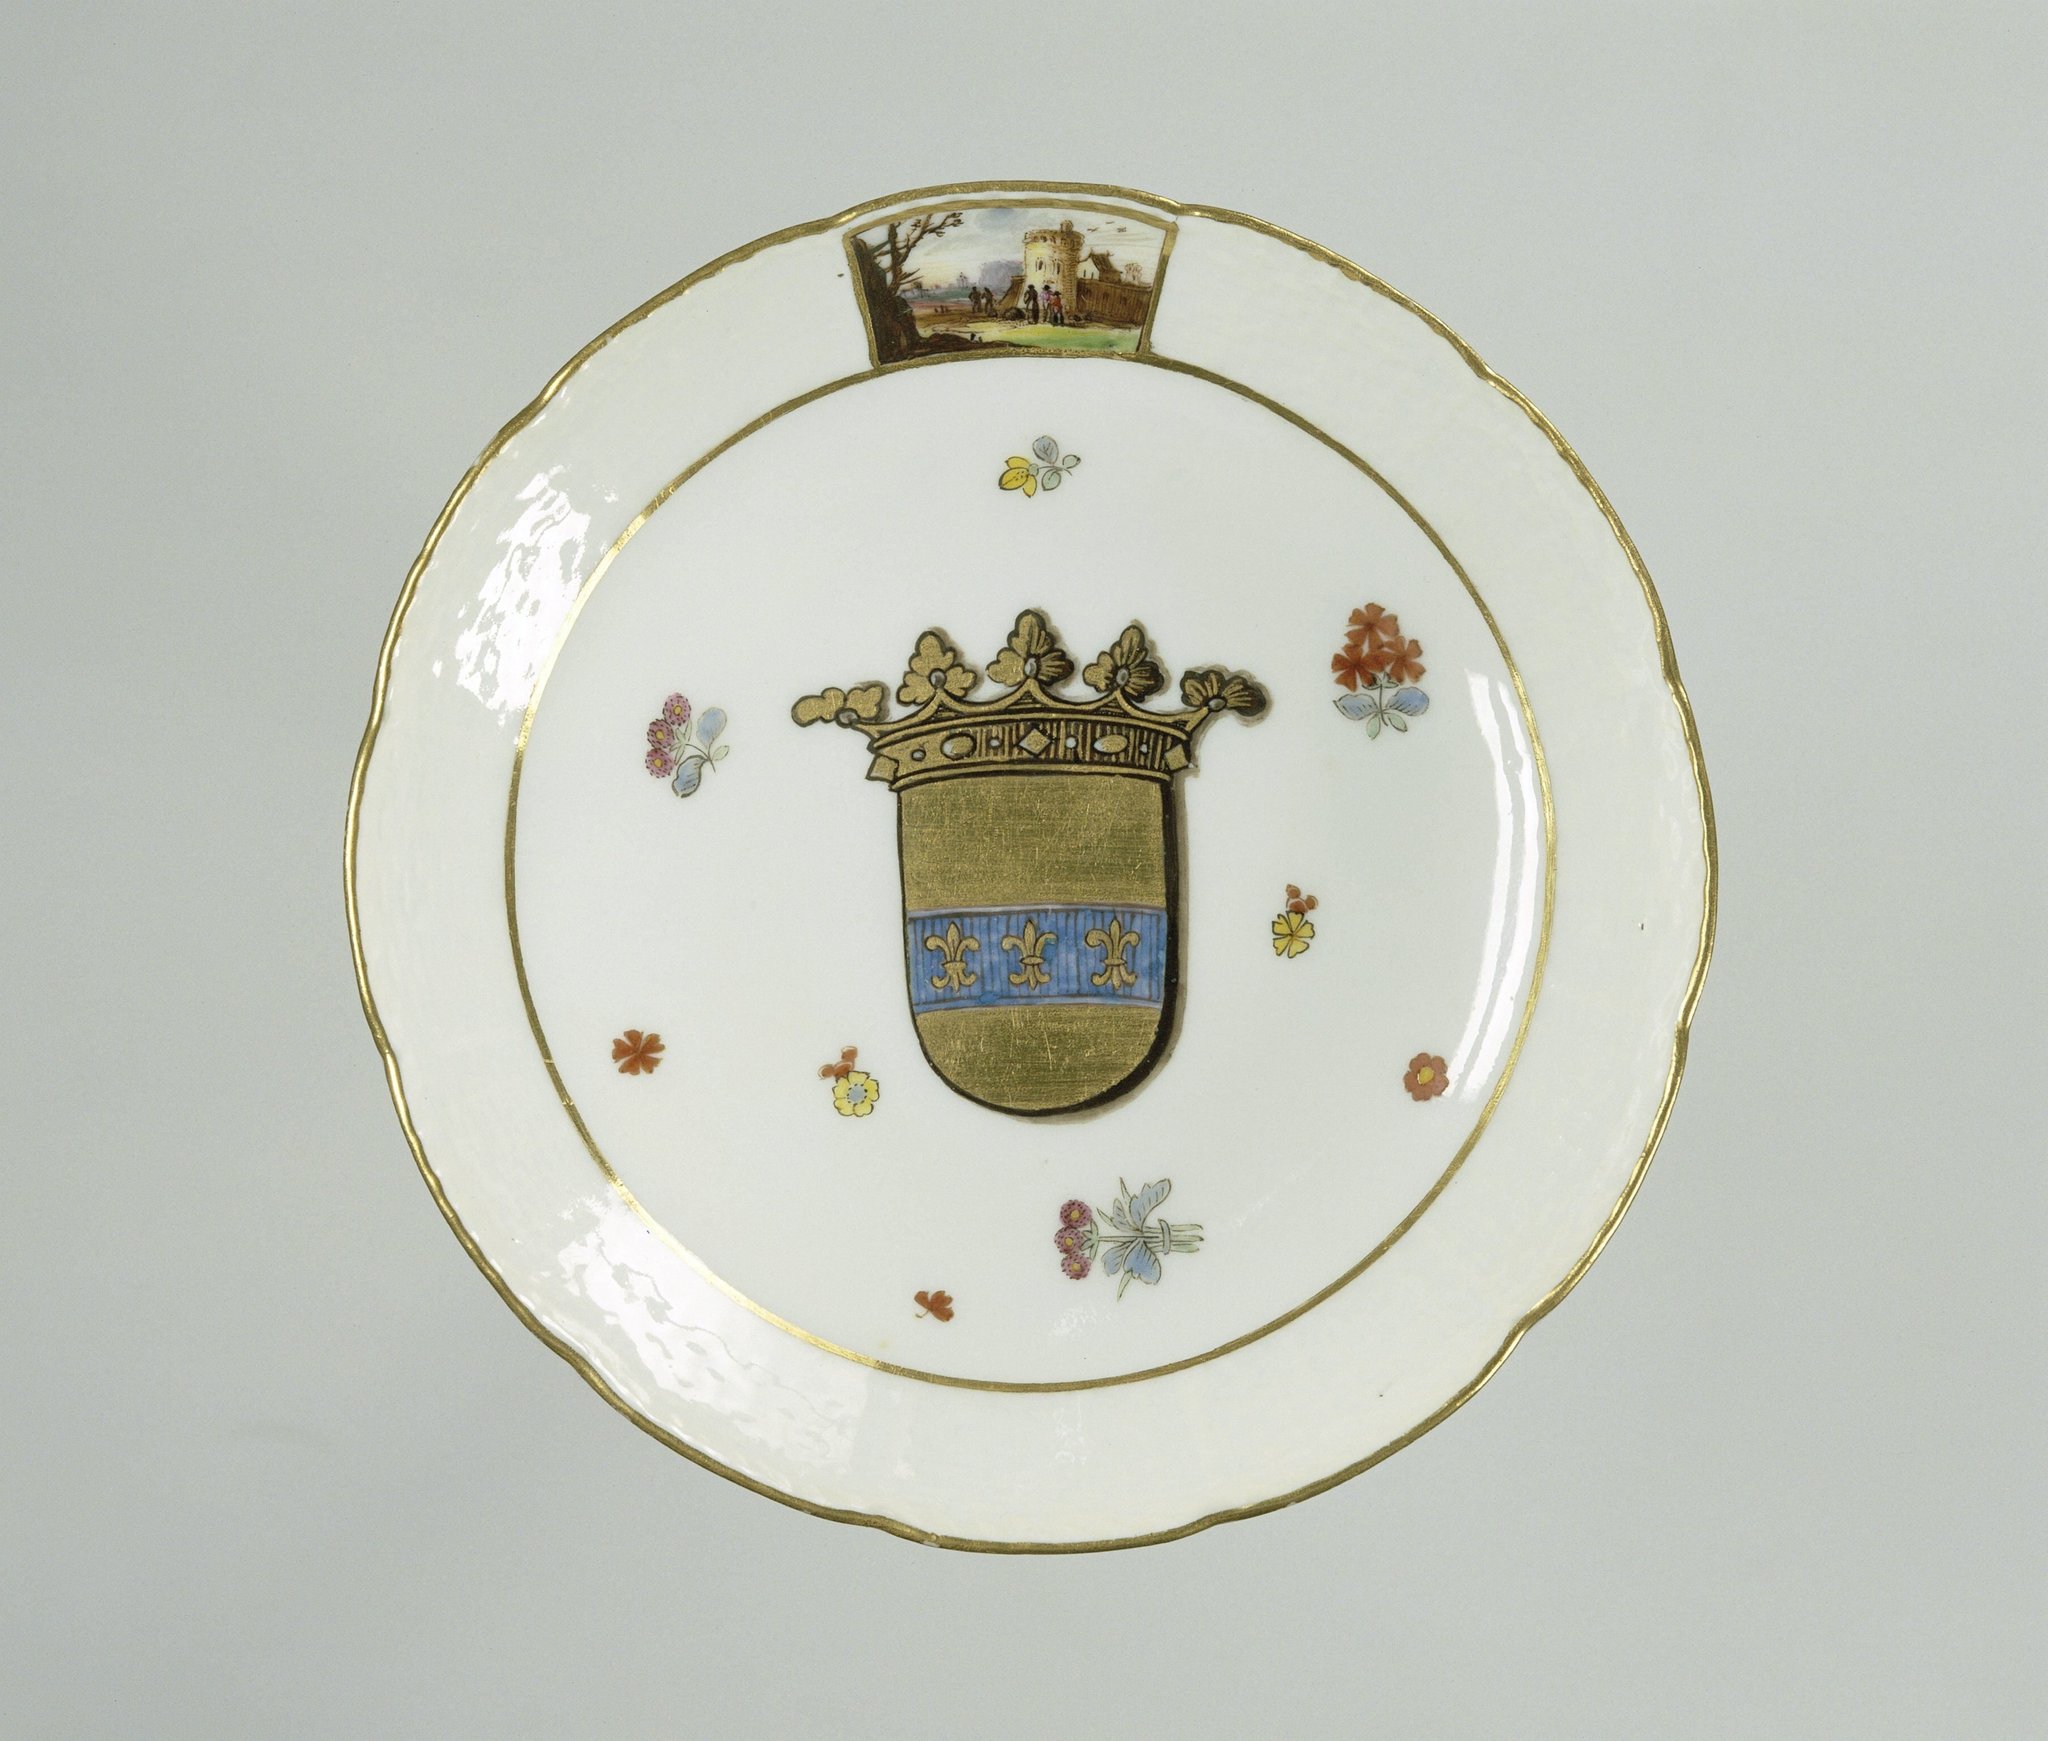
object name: eating drinking utensil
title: Schotel, veelkleurig beschilderd met een Kakiemon-decor en het wapen van de familie Querini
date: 1735-1740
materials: porcelain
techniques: painted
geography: meissen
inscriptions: factory mark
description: Schoteltje met het wapen van de graven Querini (-Stampalia). Porselein. Meissen, ca. 1735 - 1740.